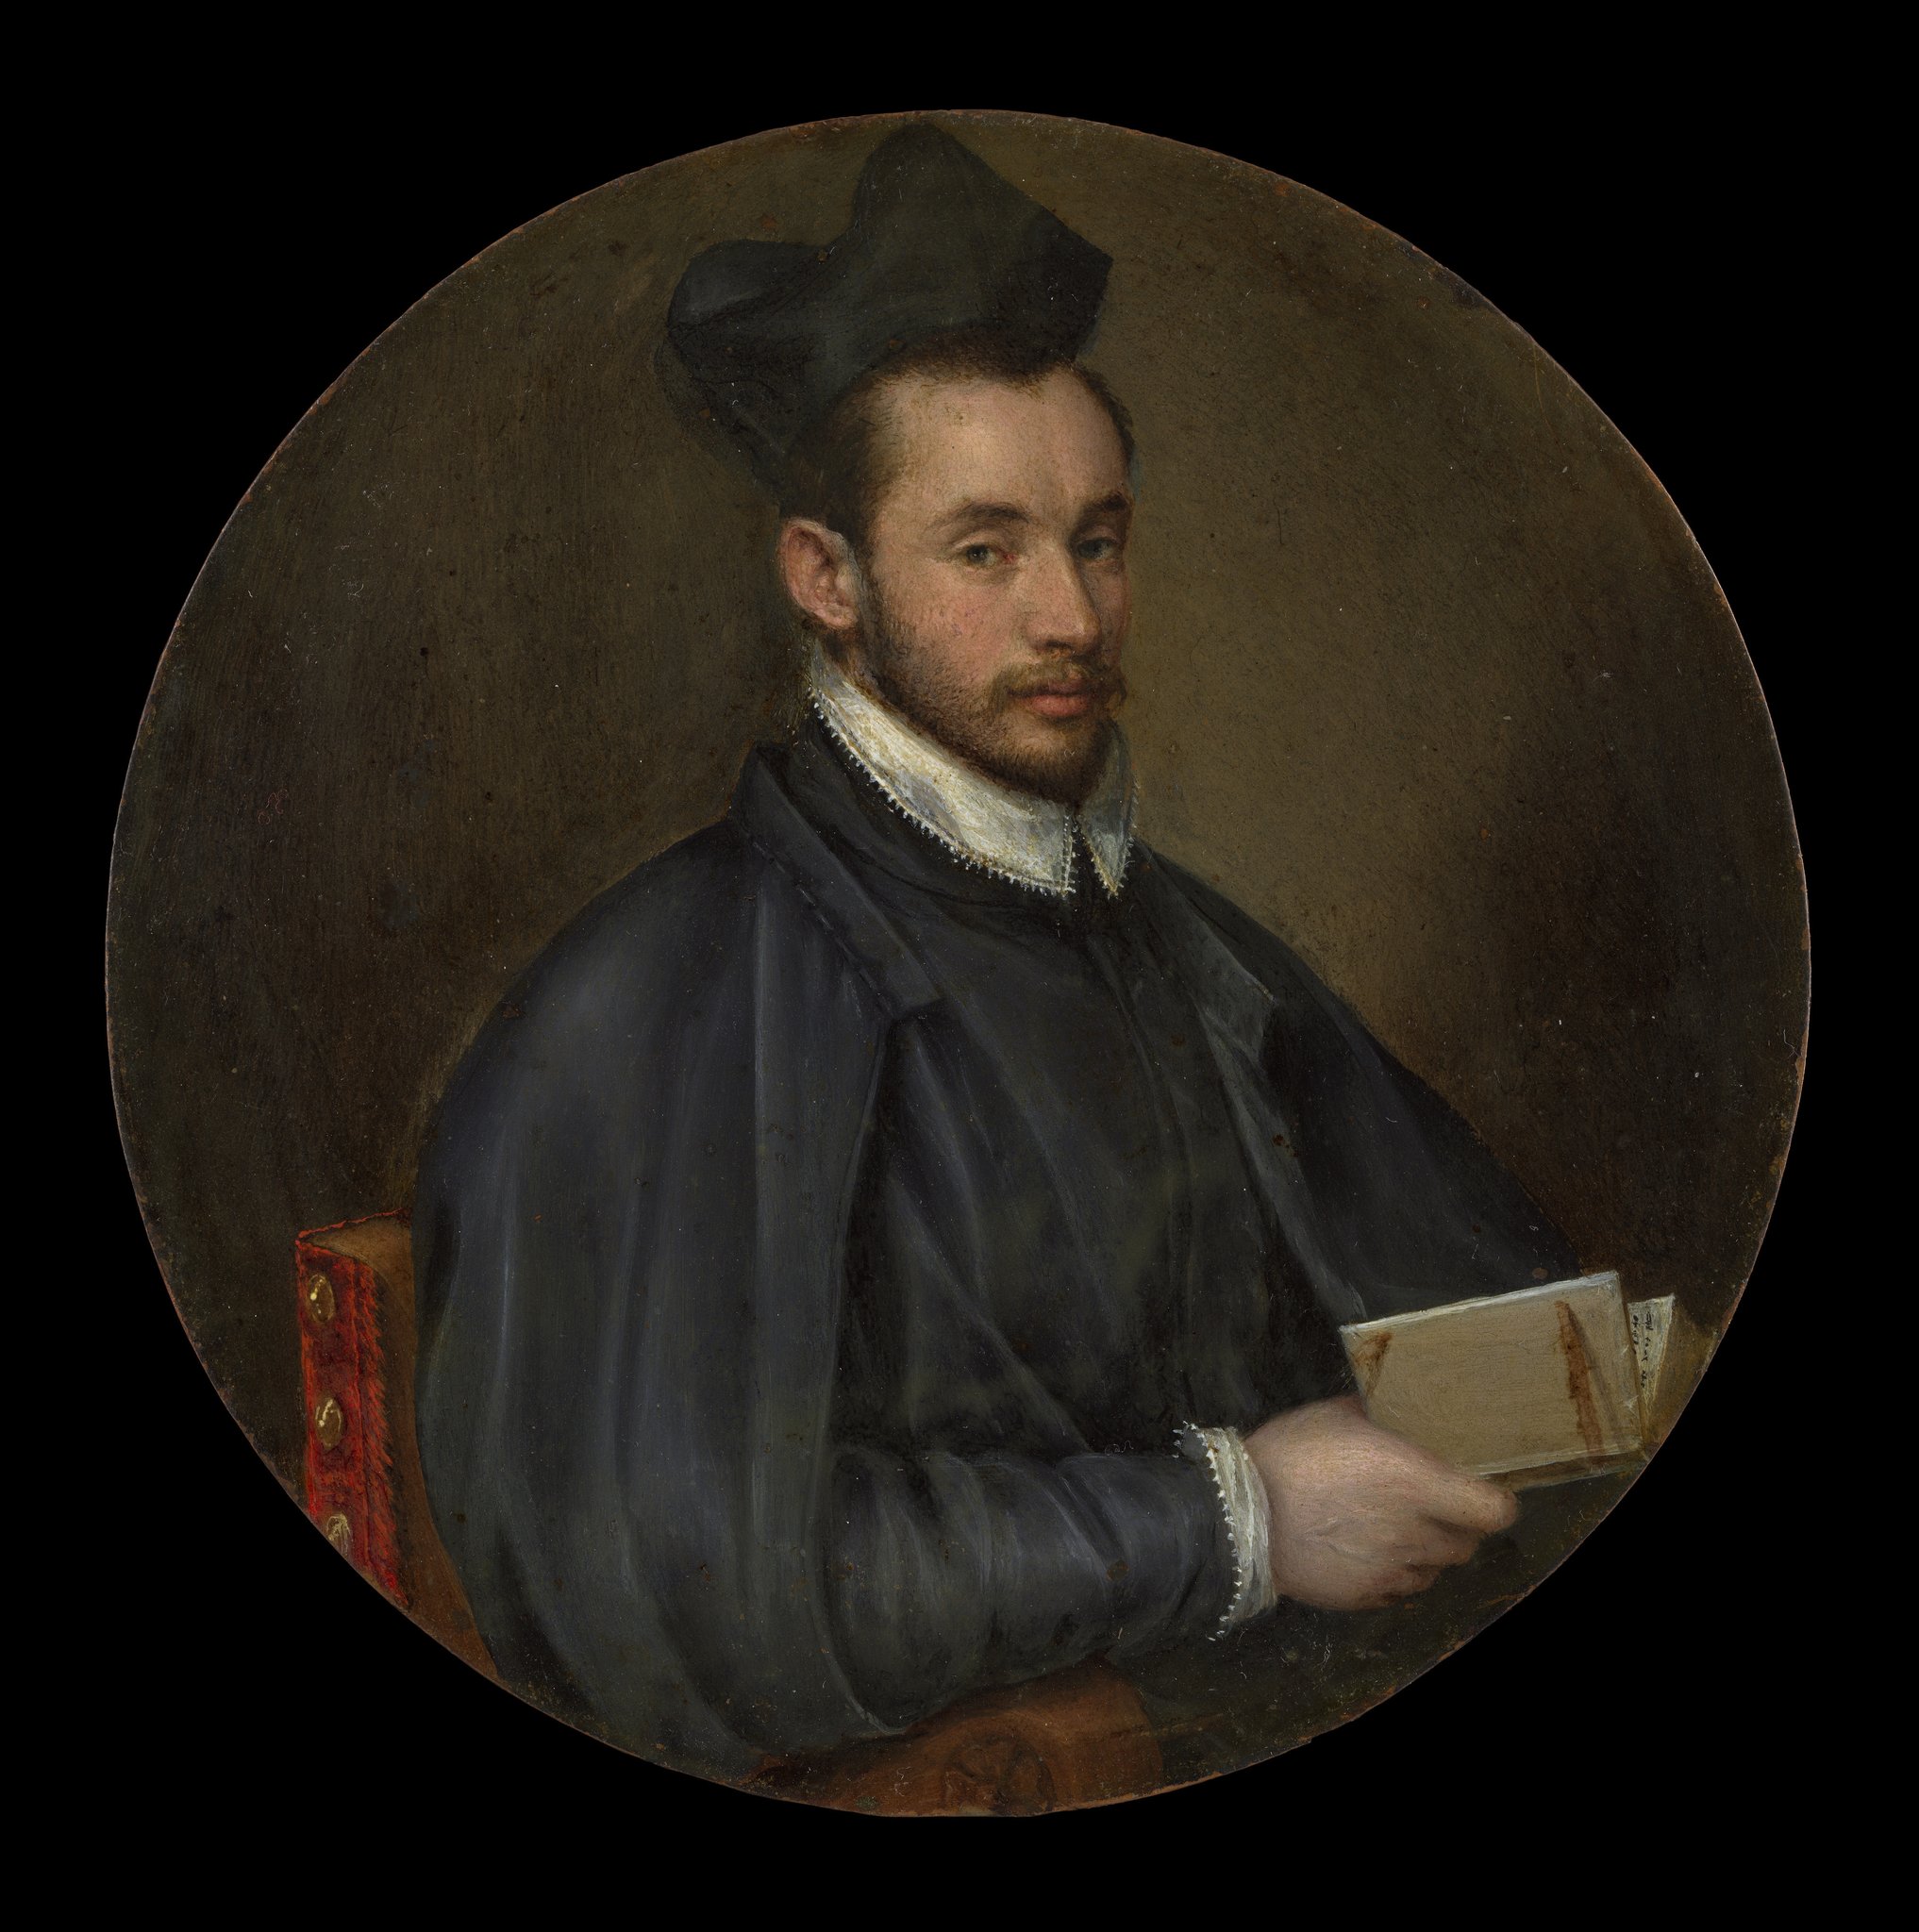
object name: painting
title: Portrait of a Prelate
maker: lavinia fontana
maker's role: artist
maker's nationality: italian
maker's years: 1552-1614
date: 1580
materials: copper, oil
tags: men,portraits